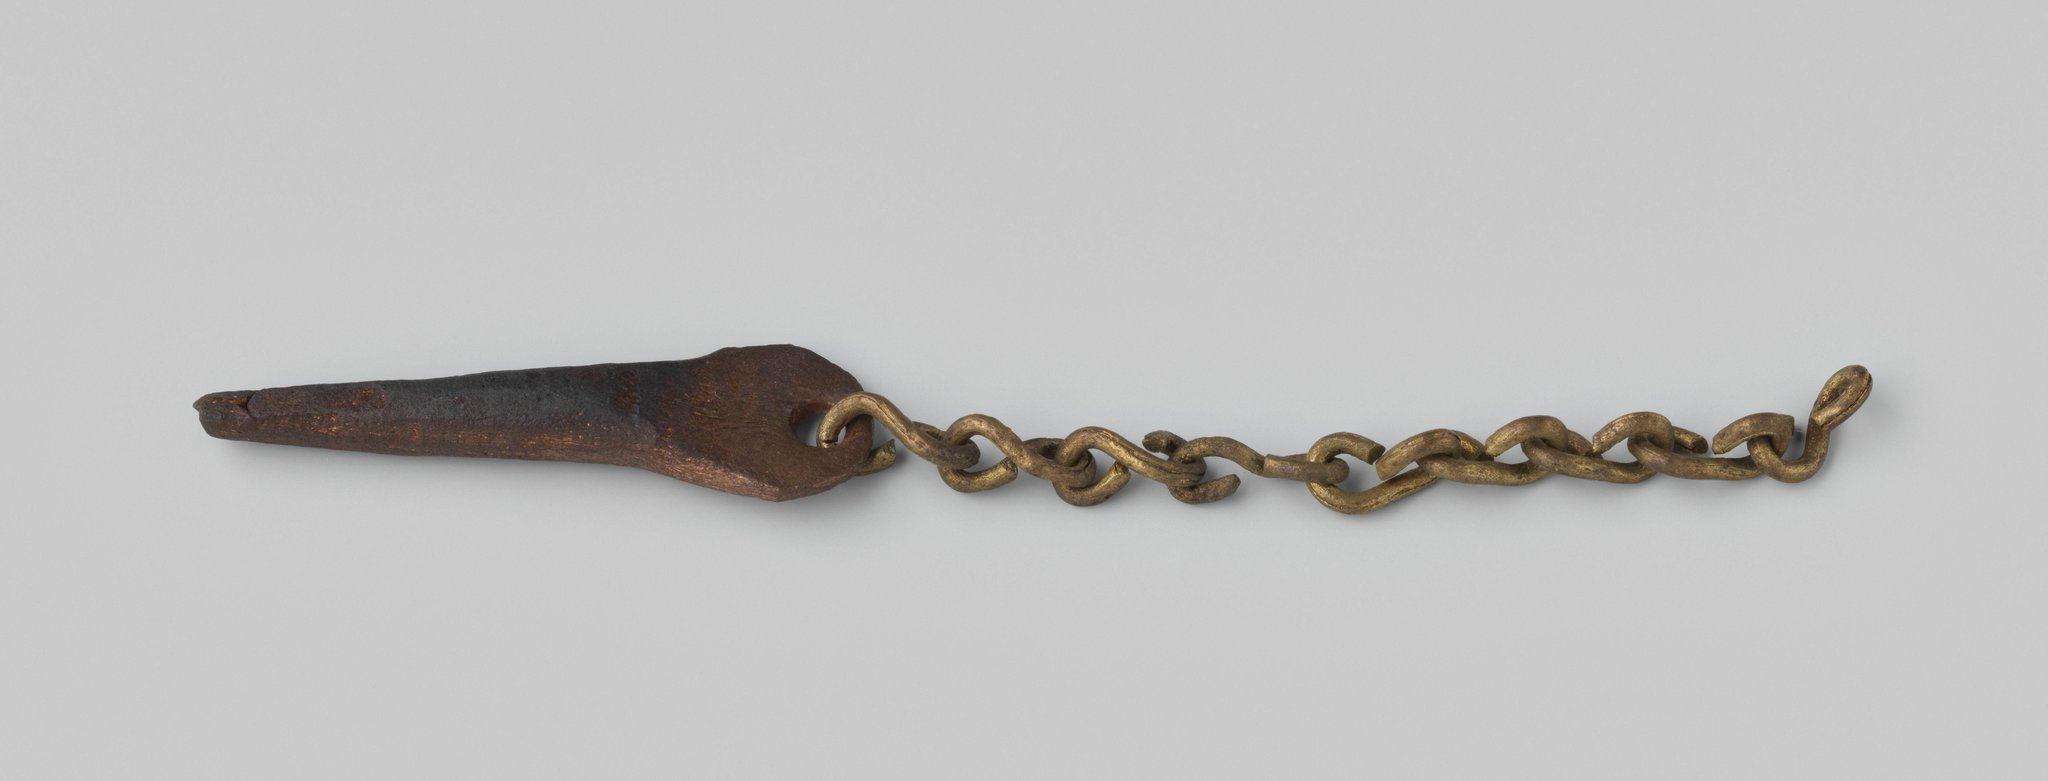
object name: wedge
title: Wig met ketting uit het wrak van de Oost-Indiëvaarder Hollandia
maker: Anonymous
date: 1700-1743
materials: copper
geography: netherlands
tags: verenigde oostindische compagnie, hollandia (schip), annet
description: Locks, fastenings and accesories, wedge; tapering, pointed lower end, circular in section, flat circular pierced upper end, upper end, inscription on shaft [XXX], fragm of chain attached through hole, id. chain NG 1980-27H87.